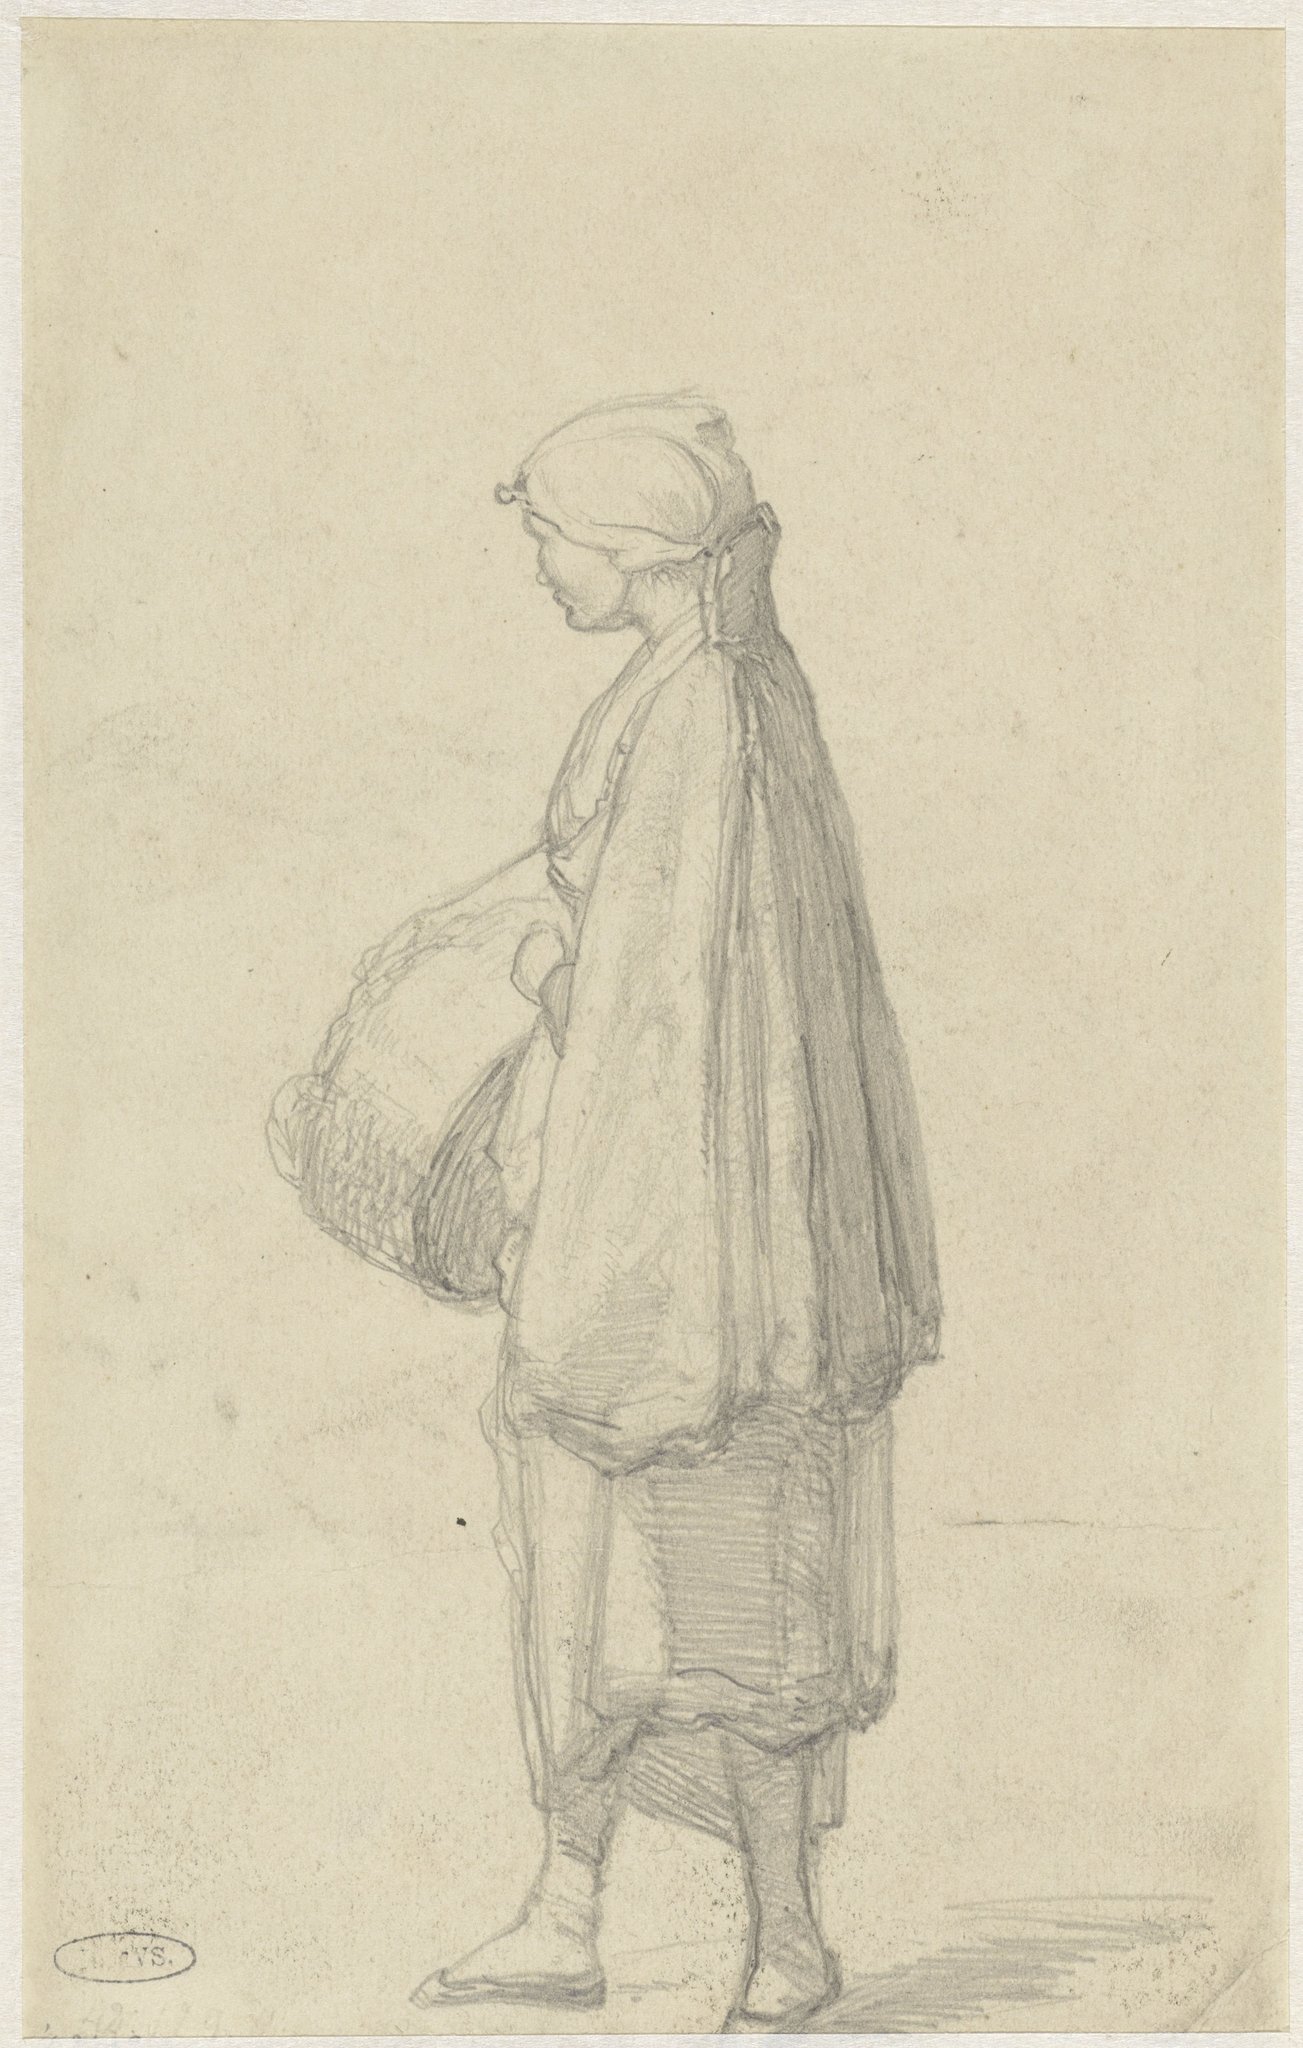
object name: drawing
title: Staande vrouw met mand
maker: willem maris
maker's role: draughtsman, painter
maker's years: 1844-1910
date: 1854-1910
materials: paper, pencil